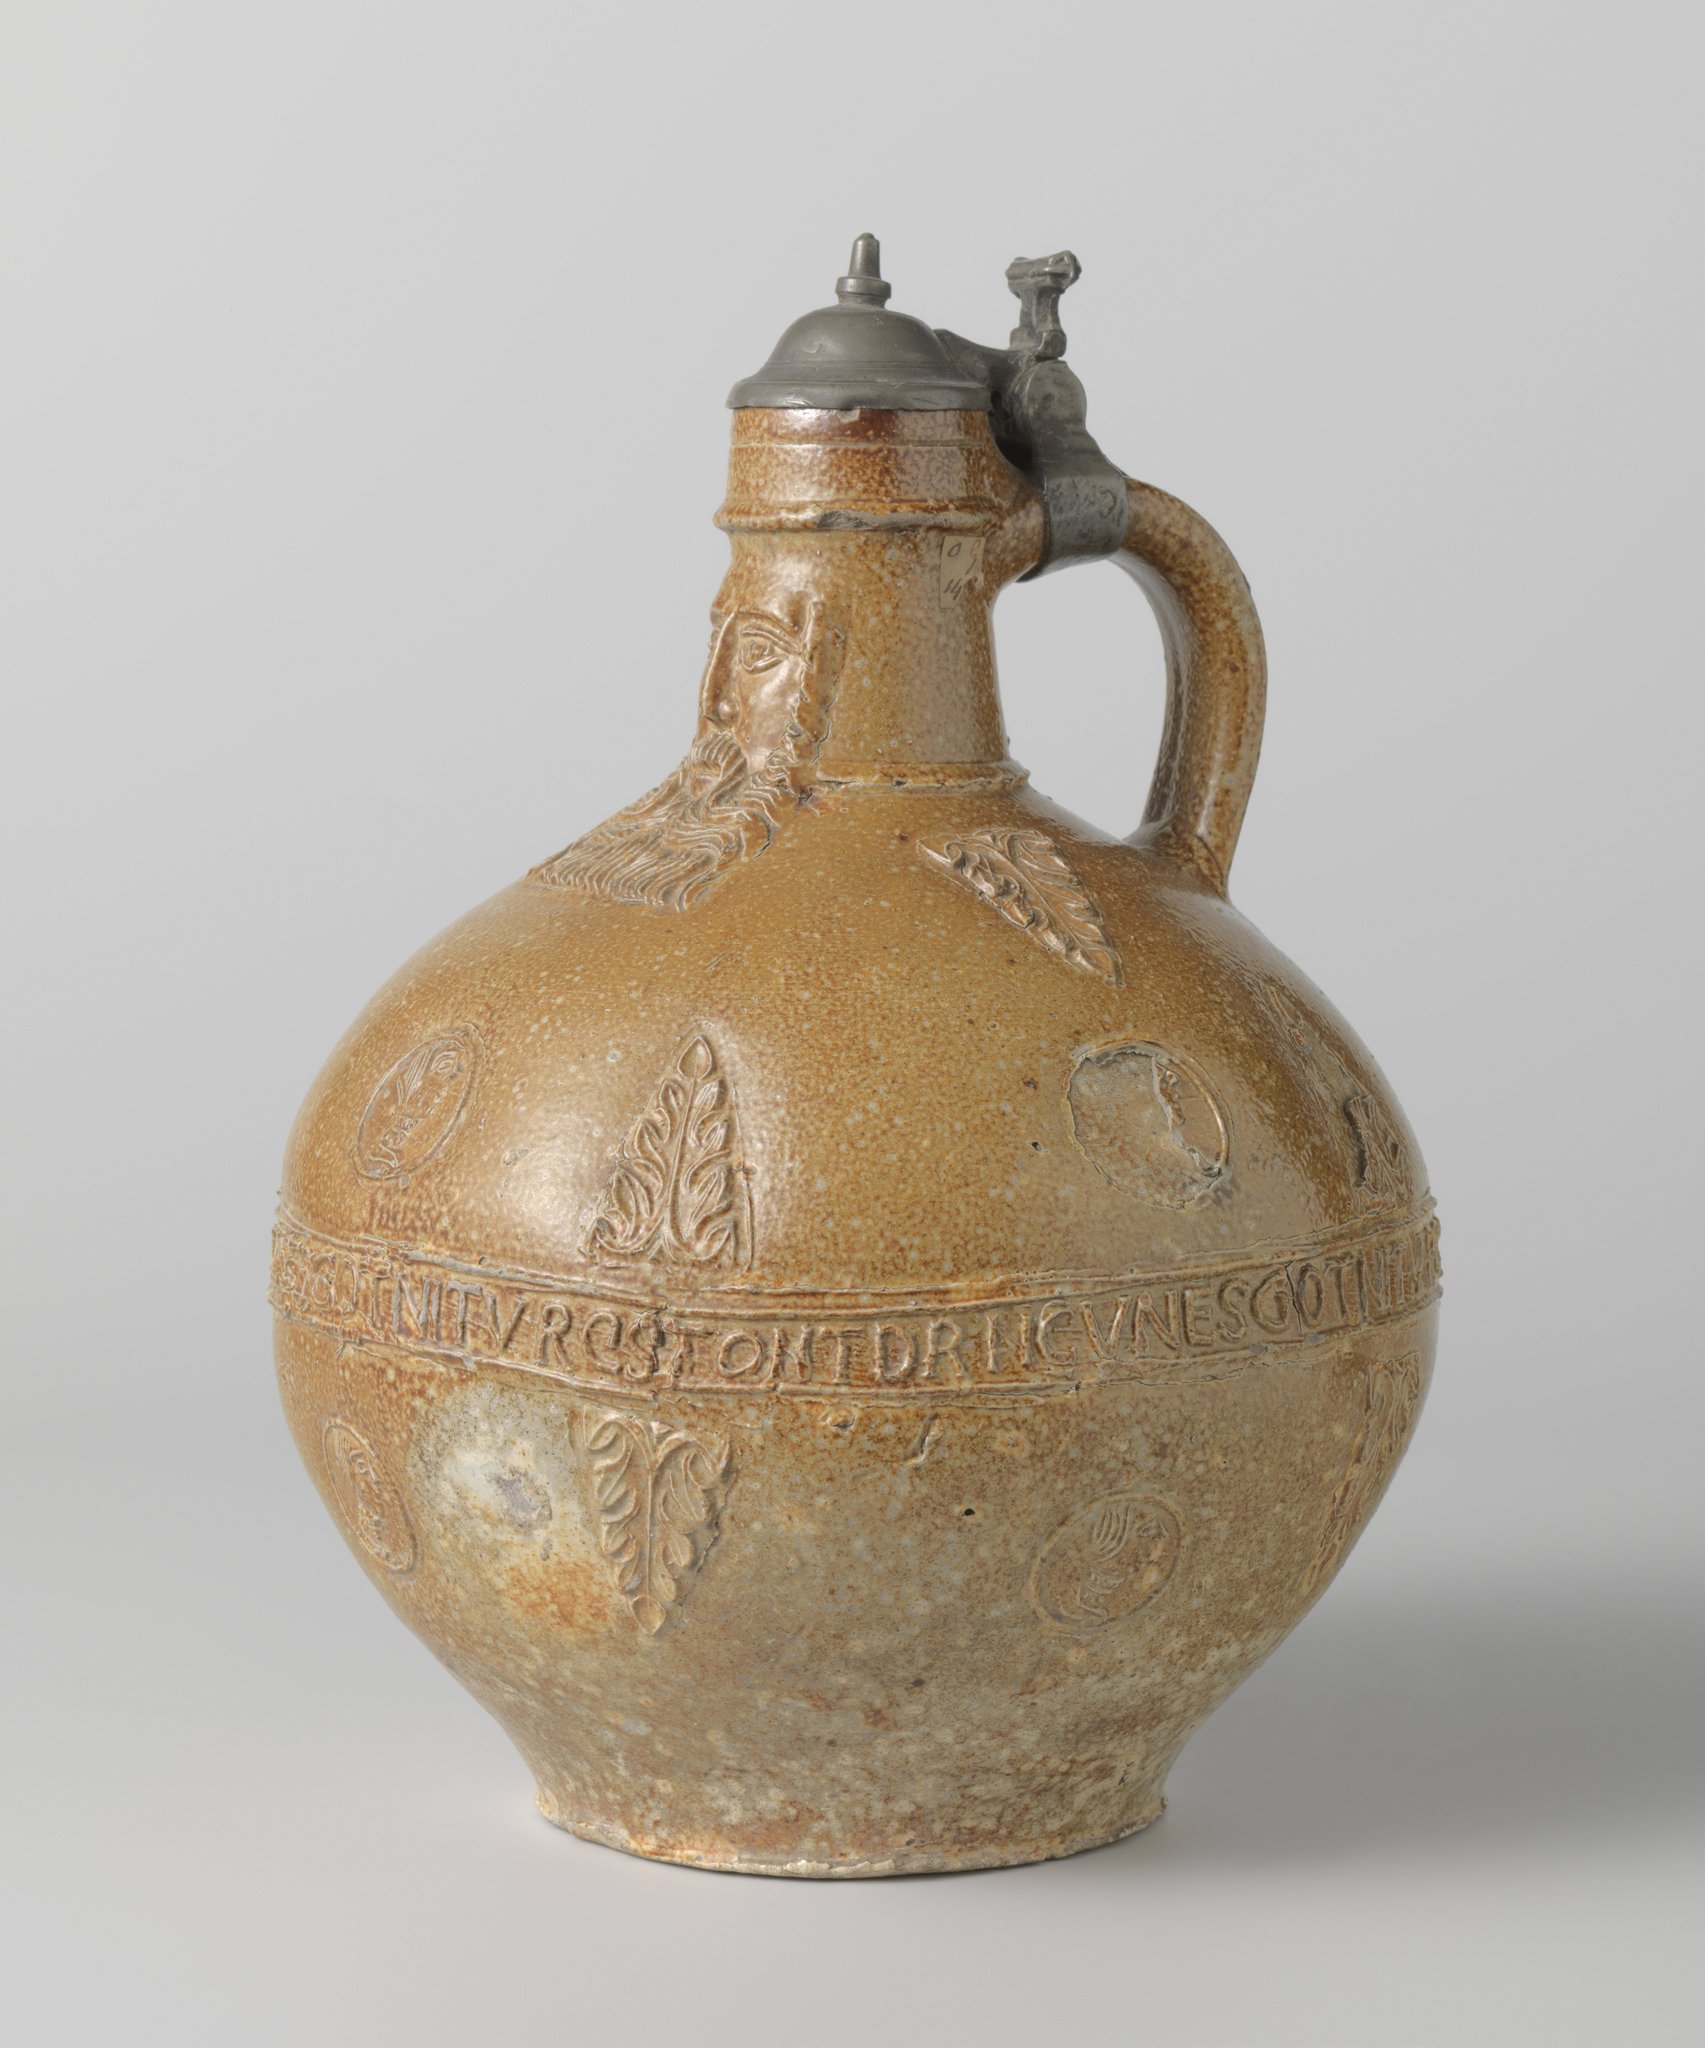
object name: jug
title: Jug (Bartmann jug) with portraits, leaves and an inscription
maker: Anonymous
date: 1540-1560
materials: engobe, glaze, stoneware, tin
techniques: firing, forming, relief, turning, vitrification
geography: frechen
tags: beard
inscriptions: inscription: ‘TONTDRNE VN ESGOT NITVRGS[?]’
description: translation of inscription: drink and eat, but forget not God